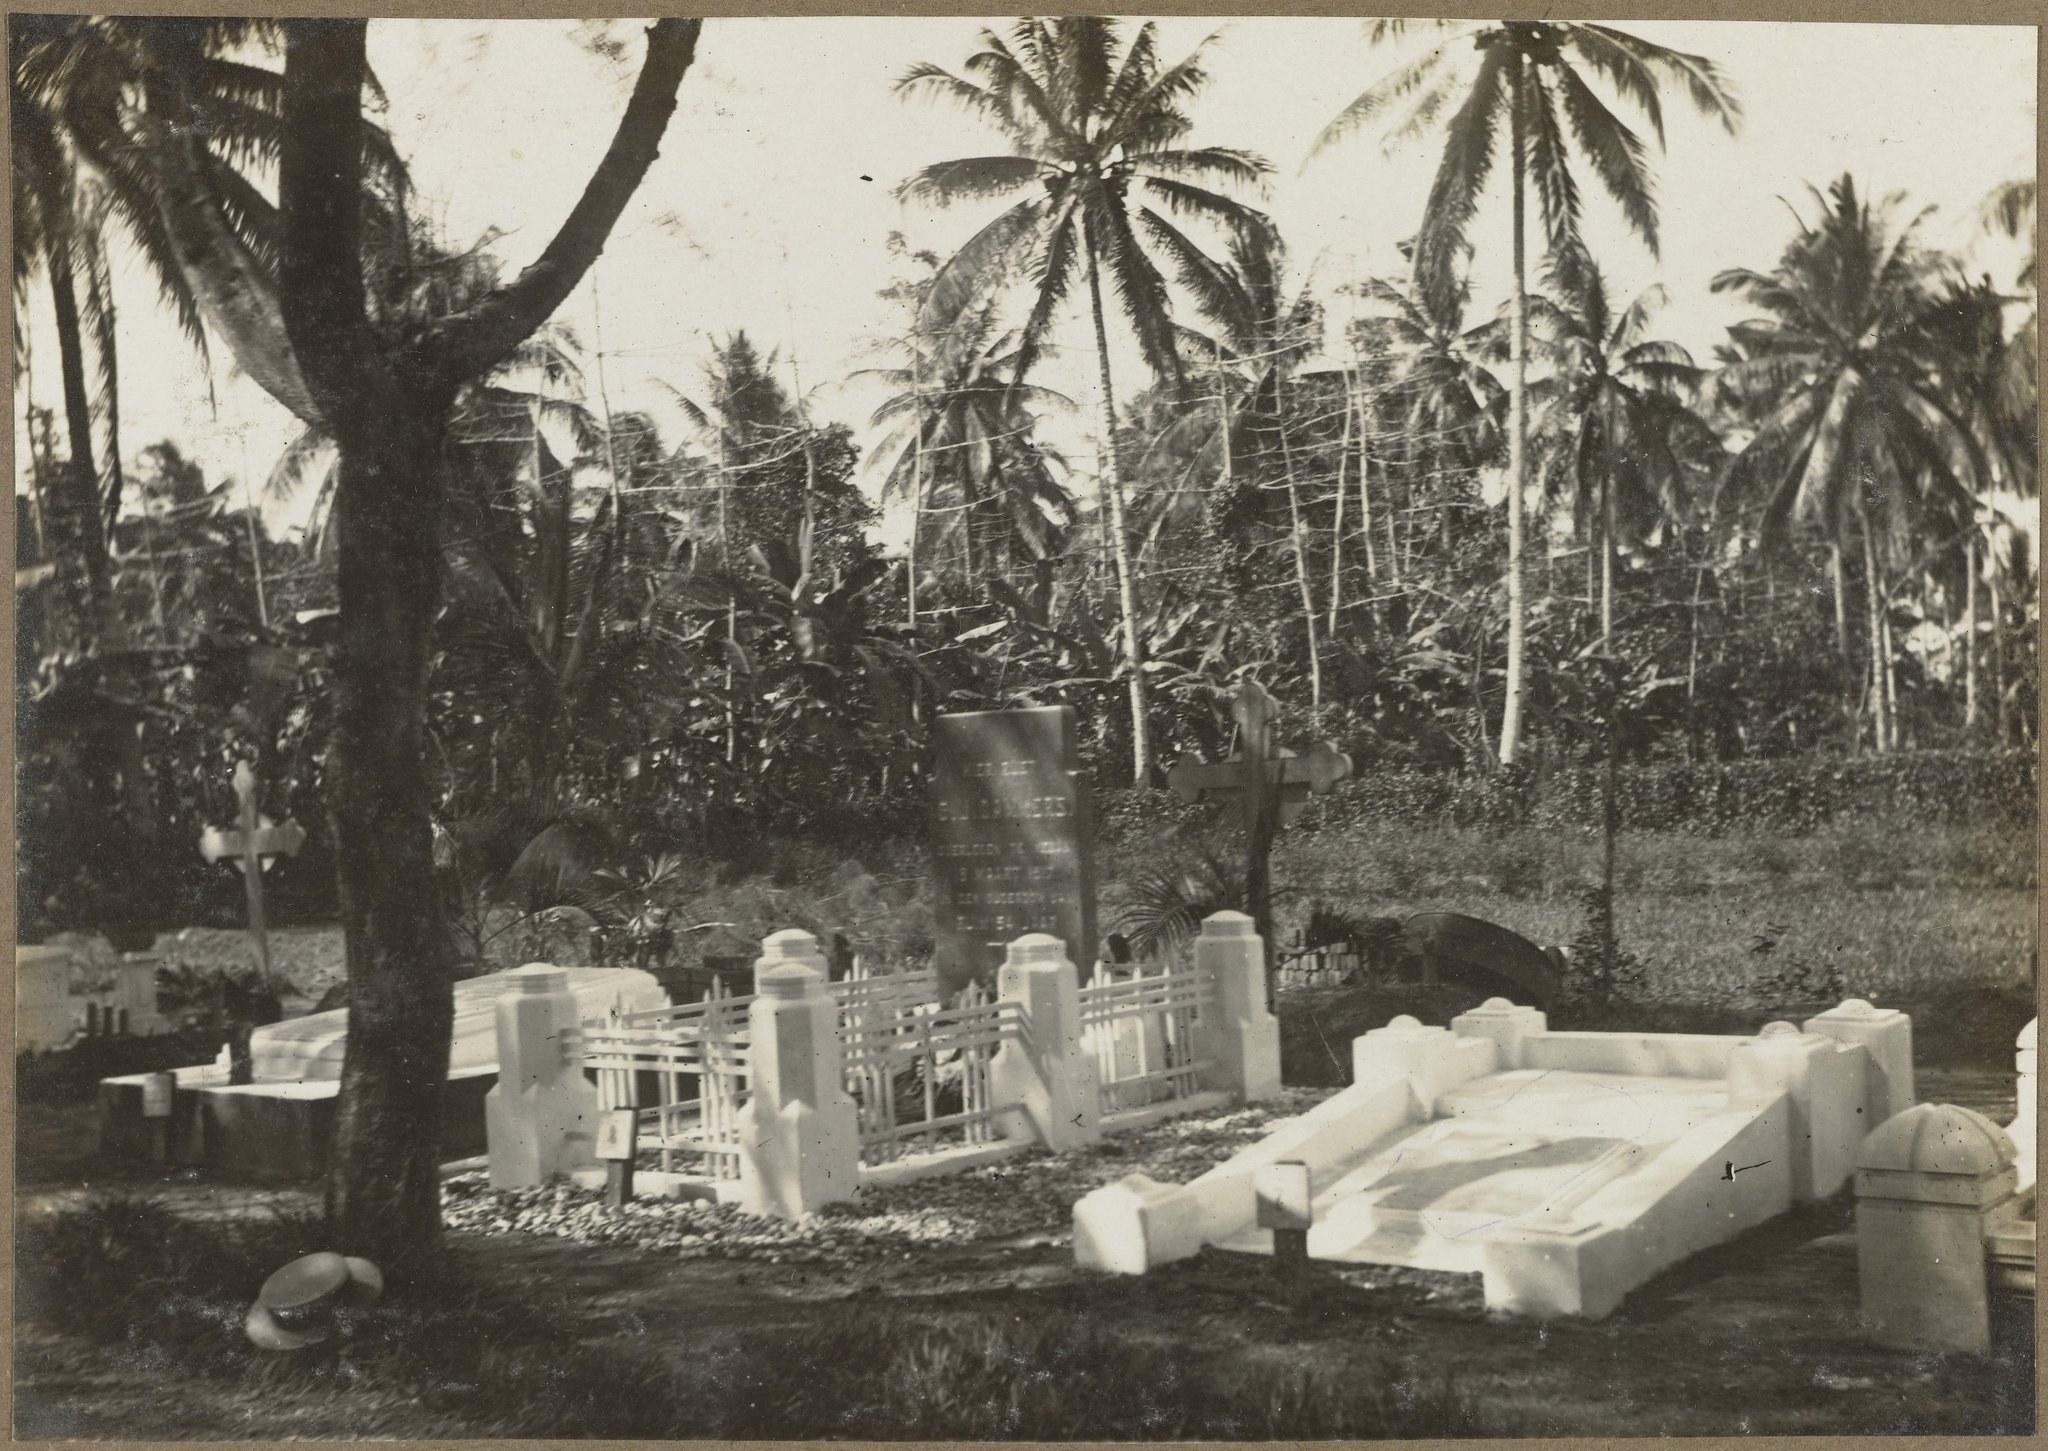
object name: photograph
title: Begraafplaats met graf van G.J. Dammers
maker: Anonymous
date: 1917-1919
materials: photographic support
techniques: gelatin silver print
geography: medan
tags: grave, tomb, churchyard, cemetery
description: Een begraafplaats te Medan met enkele graven, in het midden het graf van G.J. Dammers, overleden op 18 maart 1917. Foto in het fotoalbum van het Nederlandse architectenbureau en aannemersbedrijf Bennink en Riphagen te Medan in de jaren ca. 1914-1919.